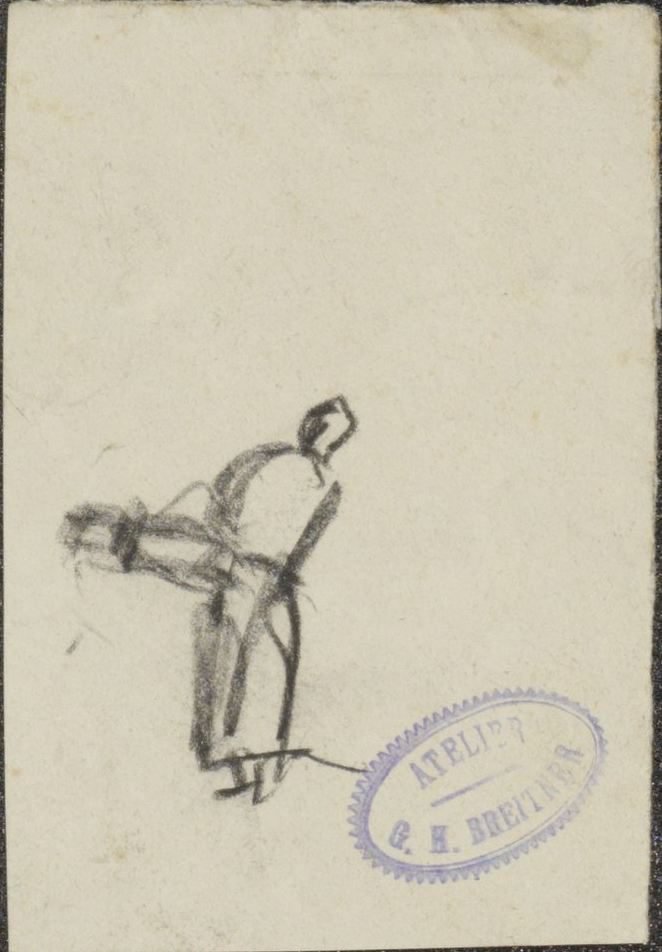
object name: drawing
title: Staande figuur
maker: george hendrik breitner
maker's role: draughtsman, painter, print maker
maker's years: 1857-1923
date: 1897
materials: chalk, paper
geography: amsterdam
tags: carrying something, standing figure - aa - female human figure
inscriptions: collector's mark: Lugt 2228, workshop stamp: Lugt 291d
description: Mogelijk een vrouw die een voorwerp draagt.